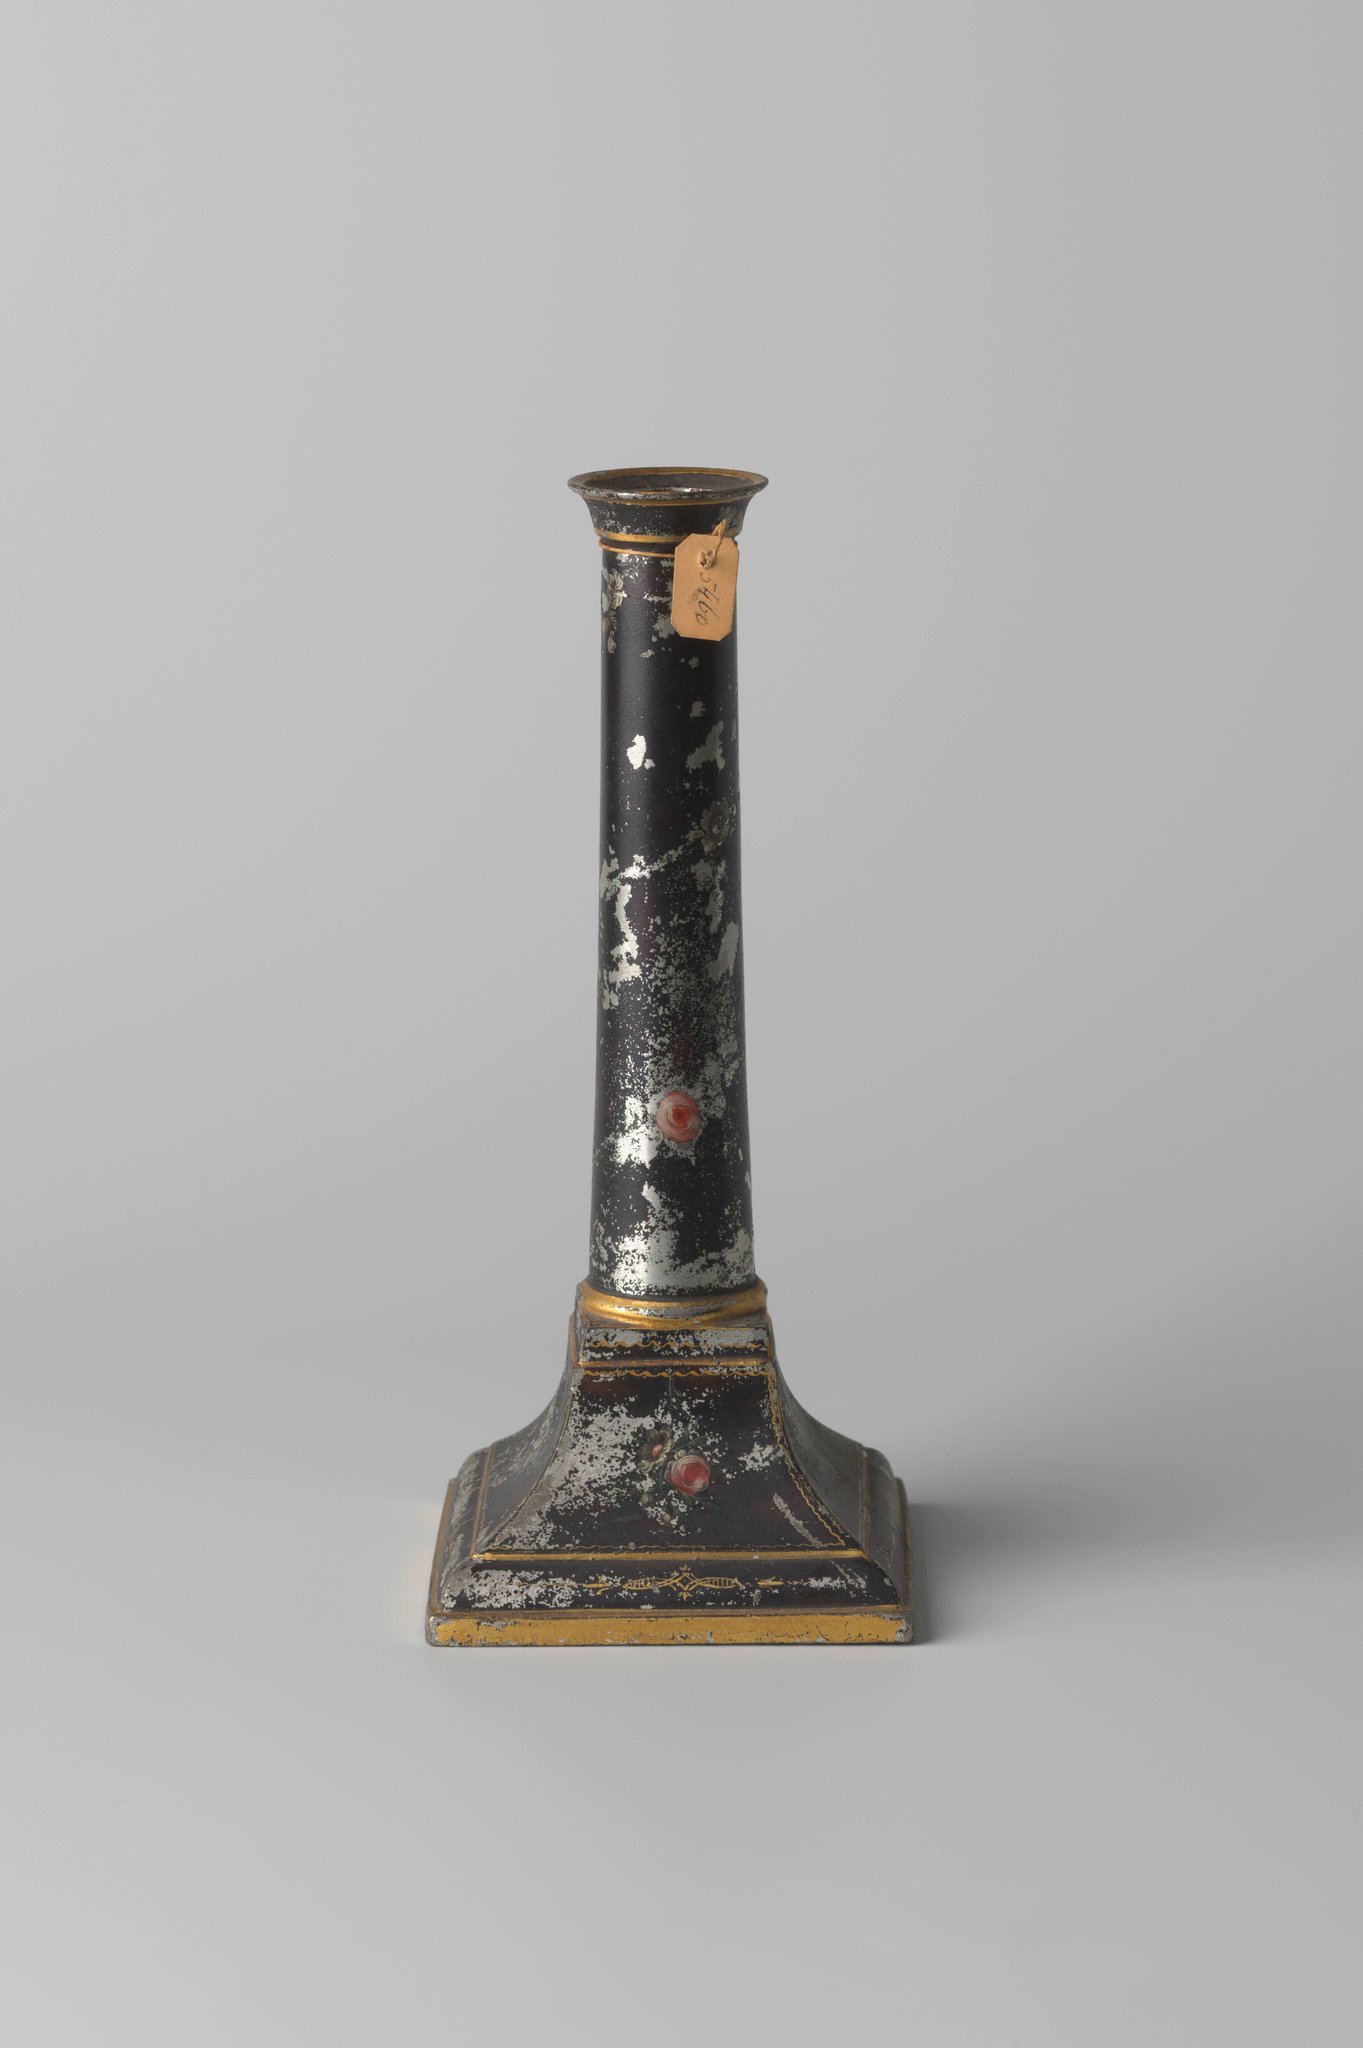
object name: candlestick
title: Zwart verlakte kandelaar met bloemen versierd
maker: carel lodewijk schurffius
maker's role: pewterers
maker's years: 1743-1812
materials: paint, tin, metal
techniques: casting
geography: amsterdam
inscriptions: quality mark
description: Kandelaar van zwart verlakt blik. Op de vierkante voet staat een vierkante basis, die holrond naar het midden toe smaller wordt, aan iedere zijde versierd met een geschilderde bloem. De cylindrische stam loopt bovenaan iets uit en is beschilderd met bloemen. Een losse kaarsenhouder die bovenin kan worden geplaatst, ontbreekt.